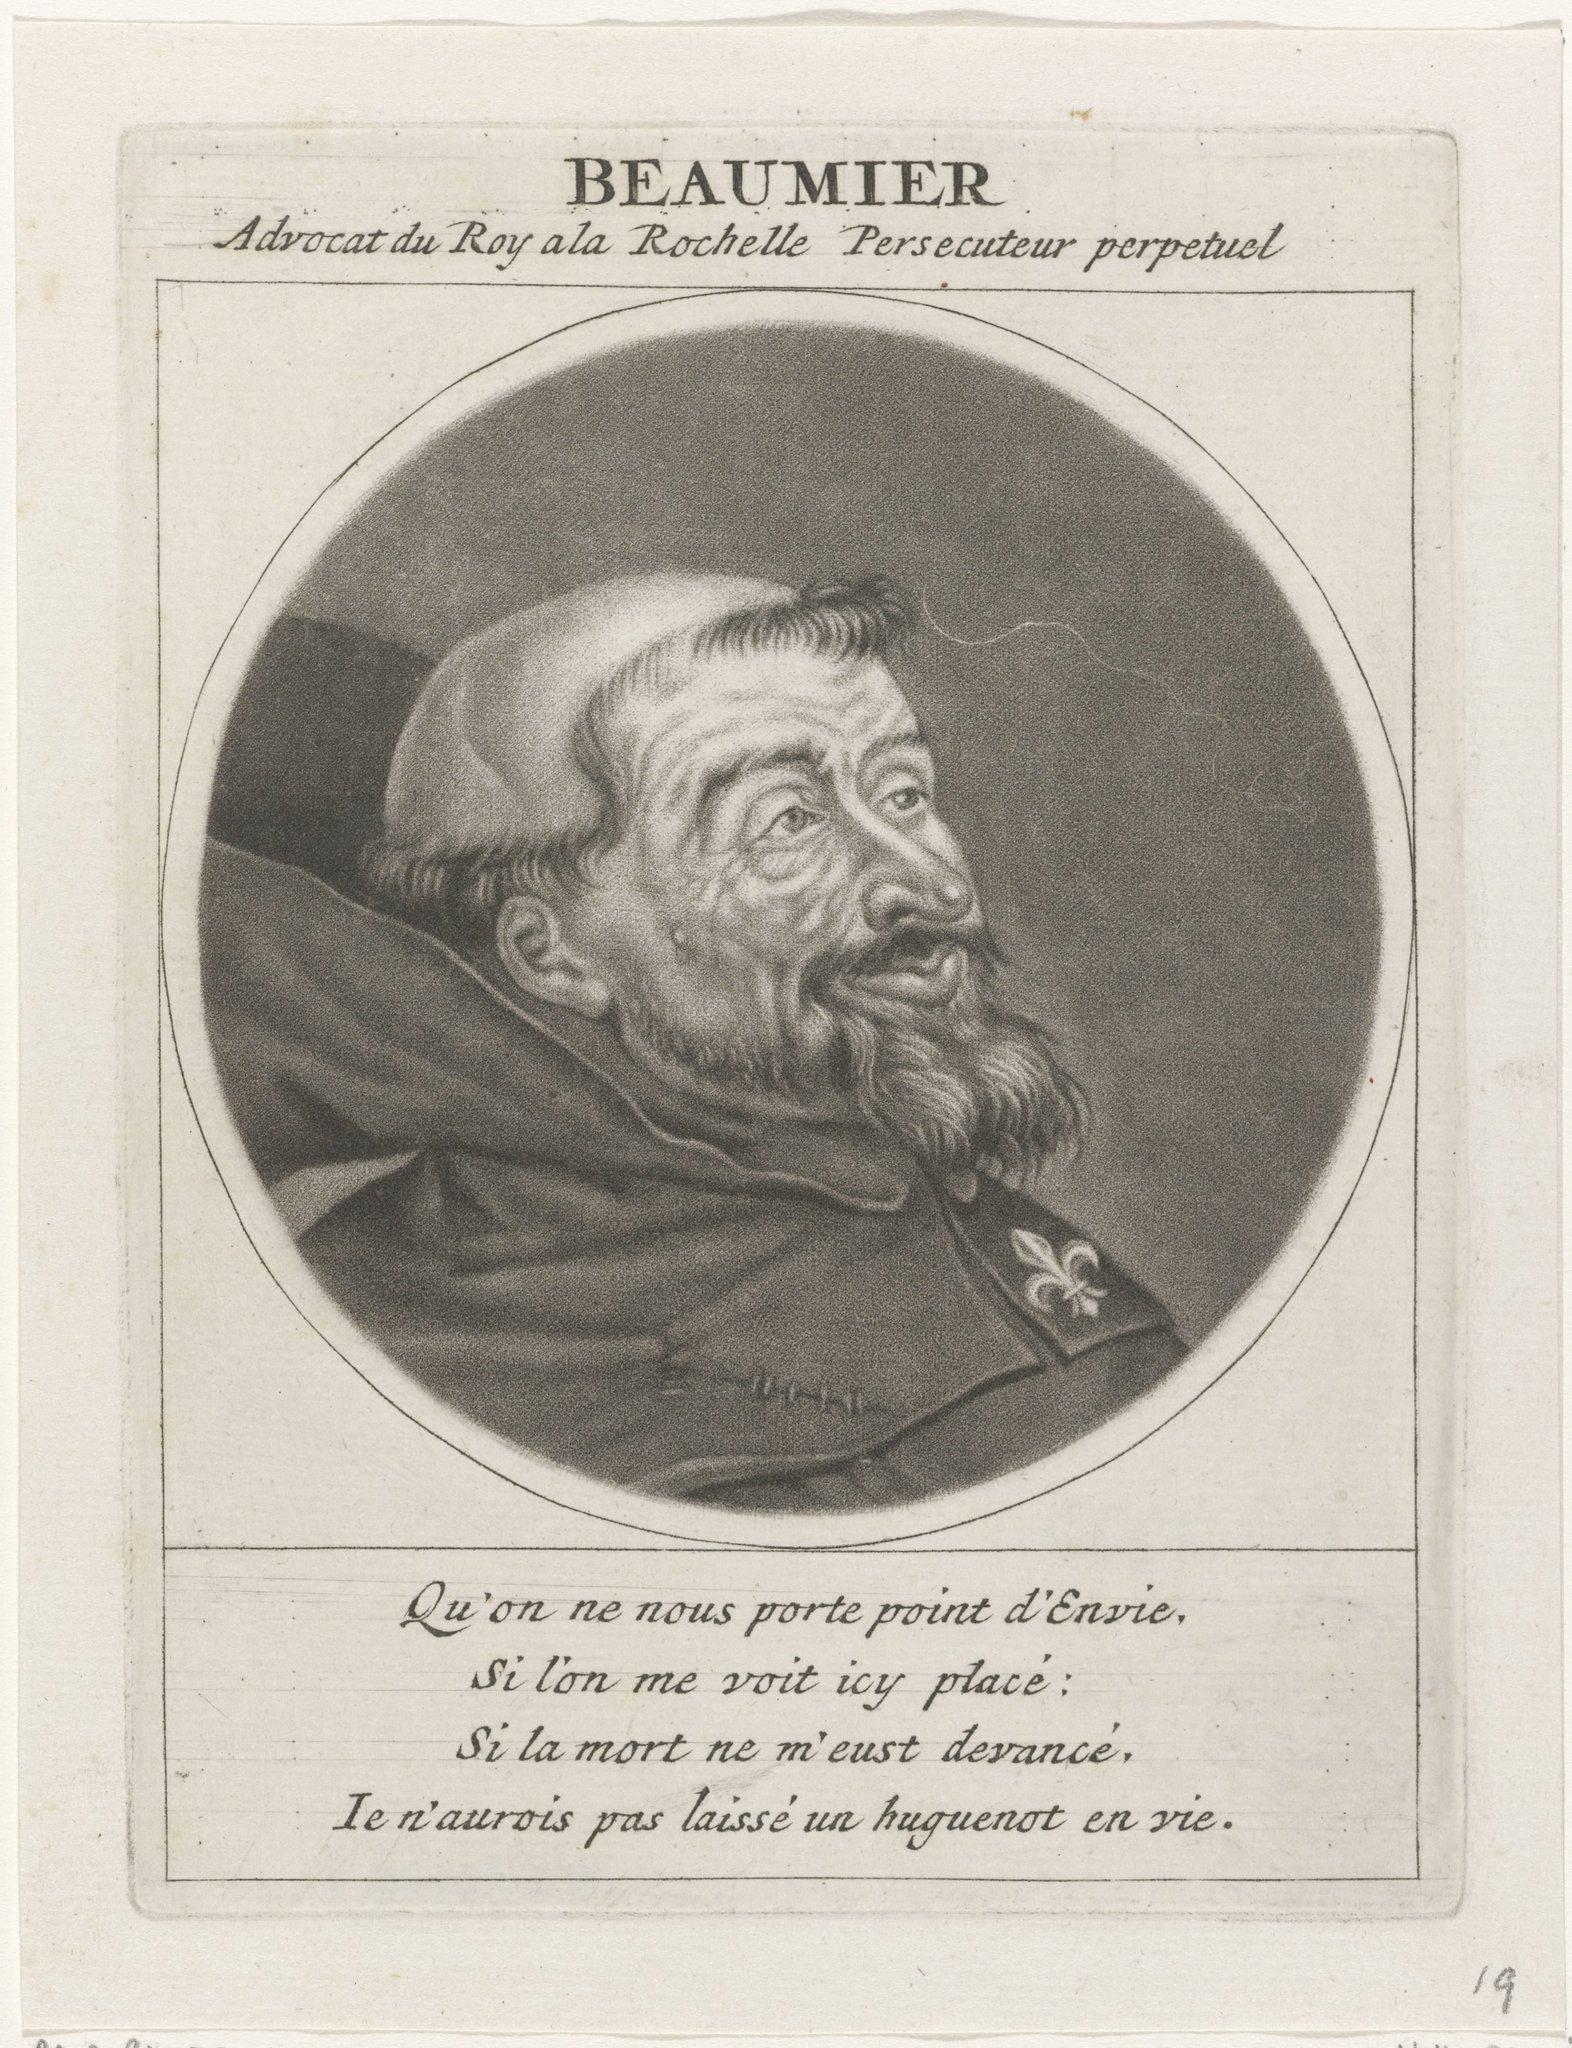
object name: print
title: Portret van Beaumier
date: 1691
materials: paper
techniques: engraving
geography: paris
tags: fleur-de-lis ~ ornament, political caricatures and satires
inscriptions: collector's mark: Lugt 240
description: Titelpagina voor: Les Heros de la Ligue: ou la procession monacale, conduitte par Louis XIV, pour la conversion des Protestants de son royaume. Chez. Pere Peters en Louis le Grand: Parijs, 1691. (De uitgevers zijn fictief.)